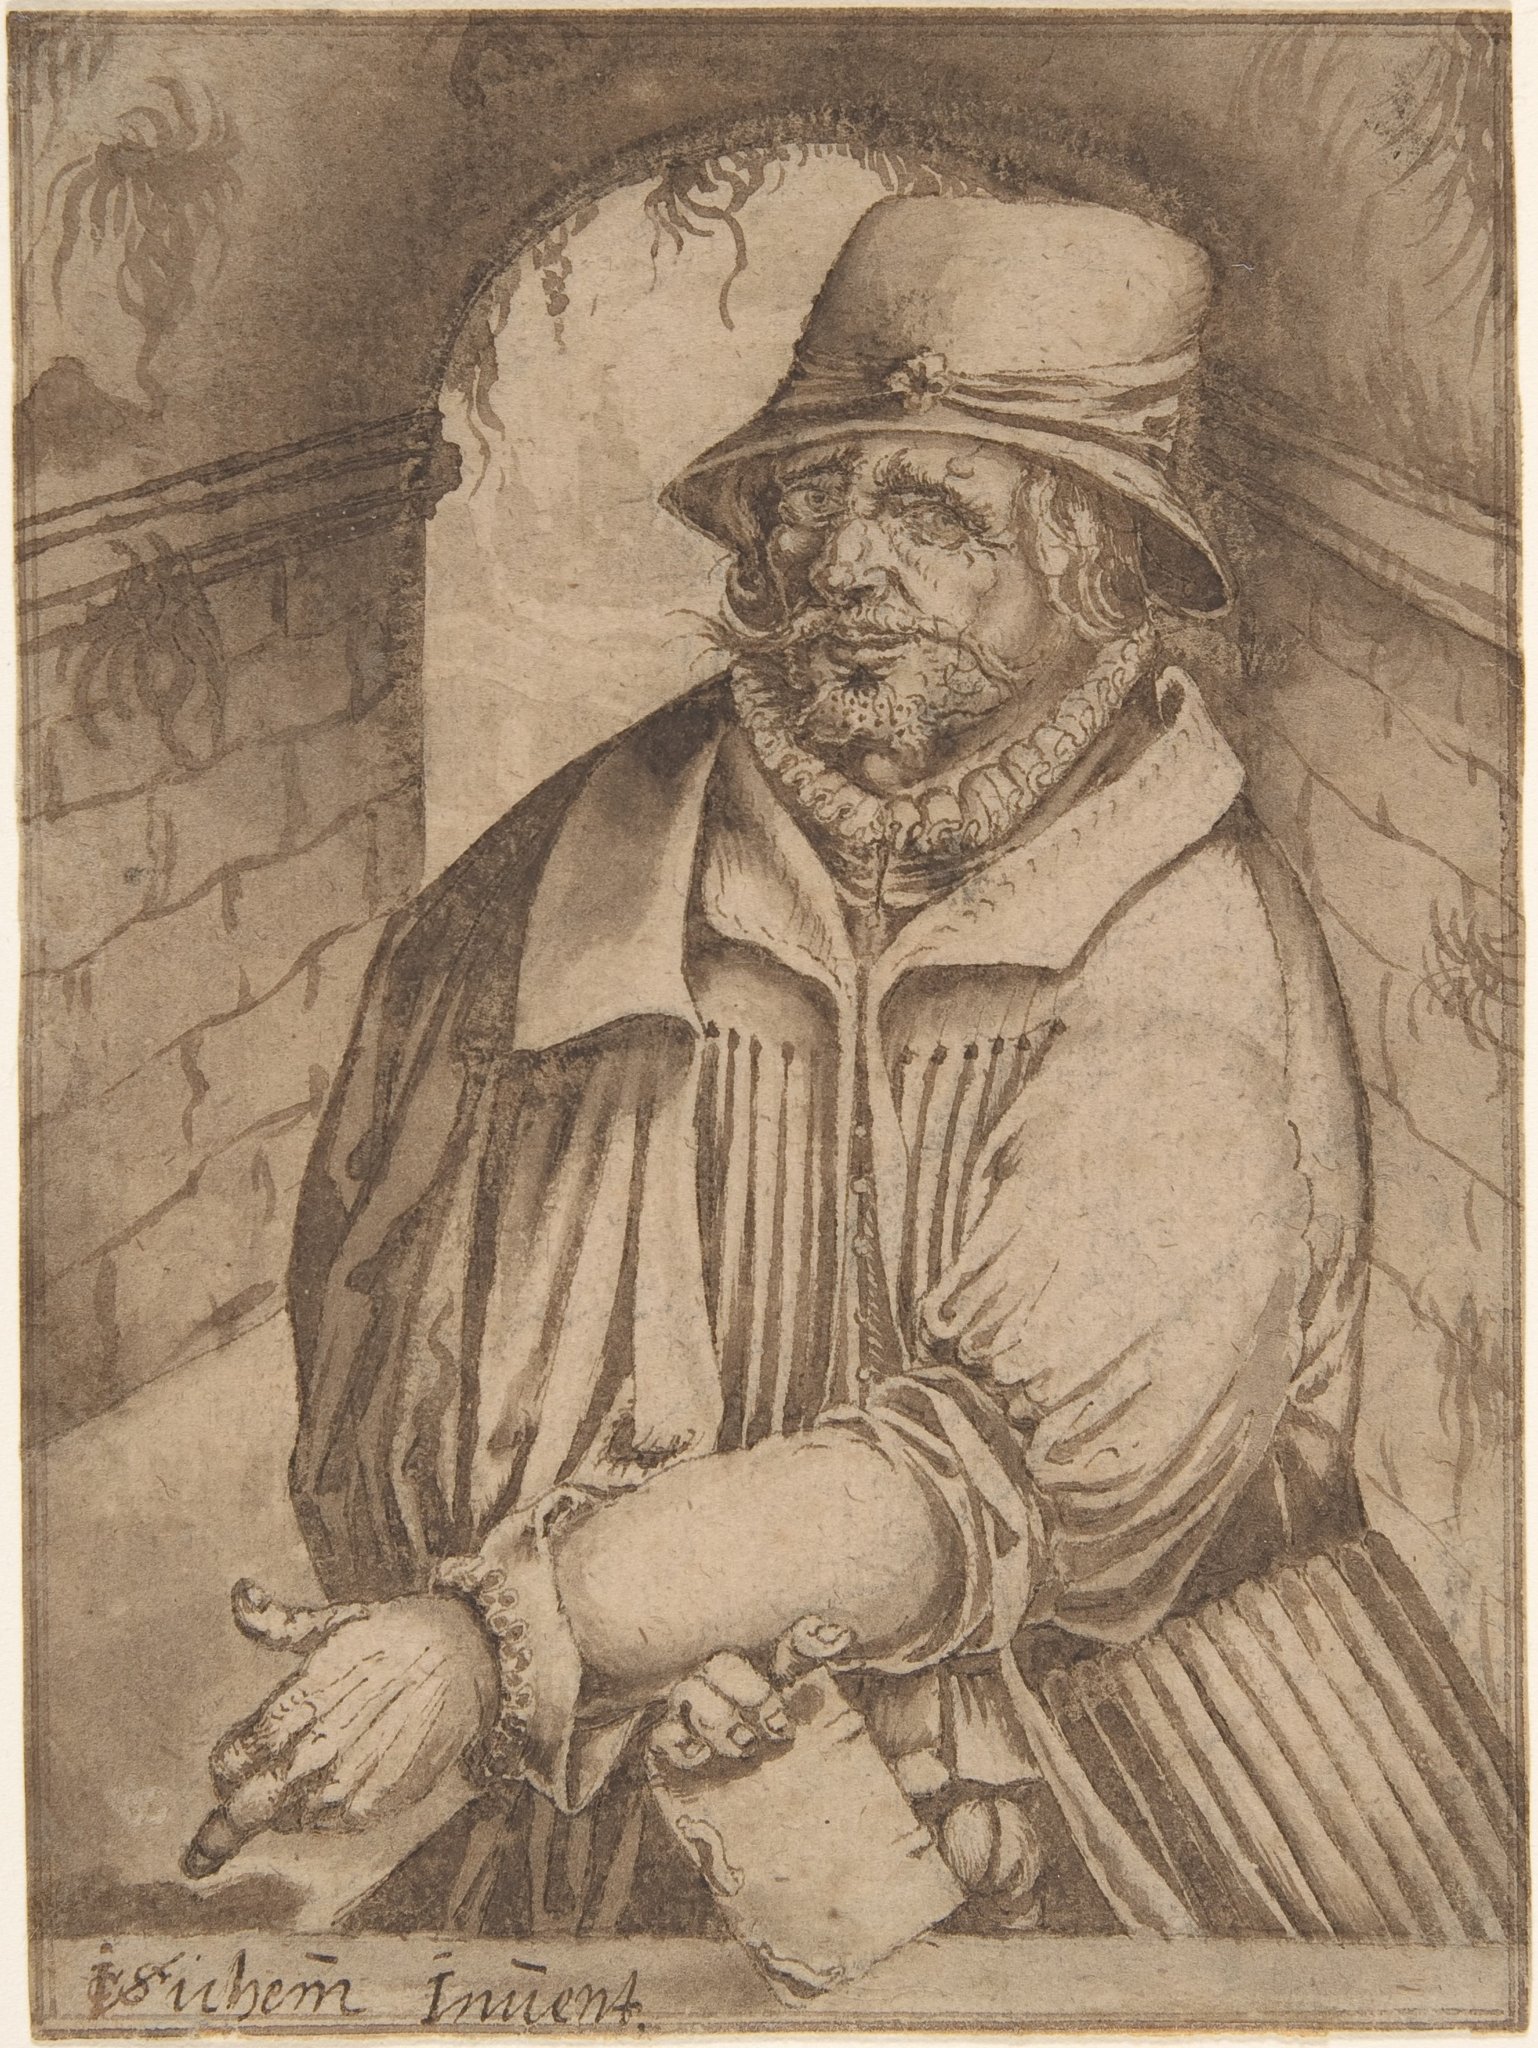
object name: drawing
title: Portrait of Jan Hus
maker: christoffel van sichem i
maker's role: artist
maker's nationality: netherlandish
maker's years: 1546-1624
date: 1534-1633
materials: ink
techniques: incising, pen, transfer, wash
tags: men,portraits